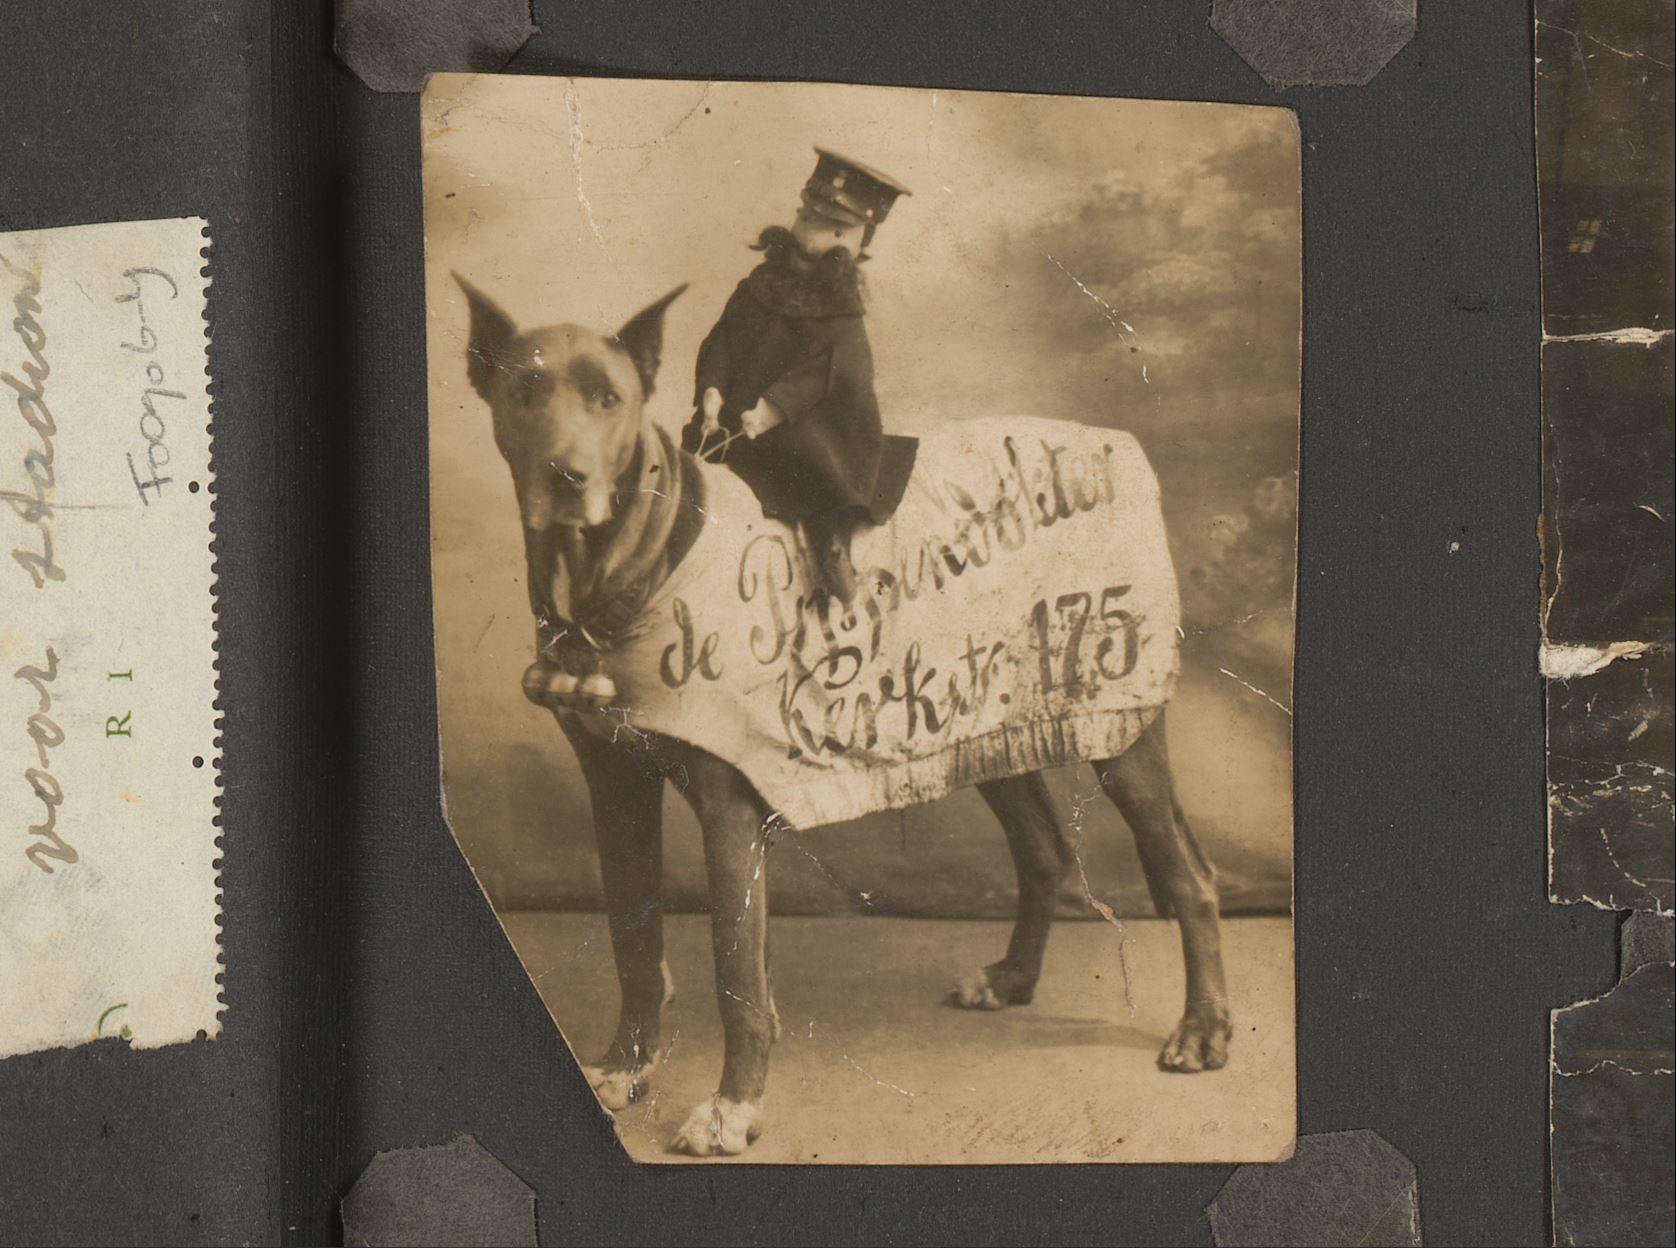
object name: album leaf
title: Portret met een hond met pop en reclametekst van de poppendokter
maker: Anonymous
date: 1930-1940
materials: photographic support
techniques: gelatin silver print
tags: advertising, dolls for adults, dog